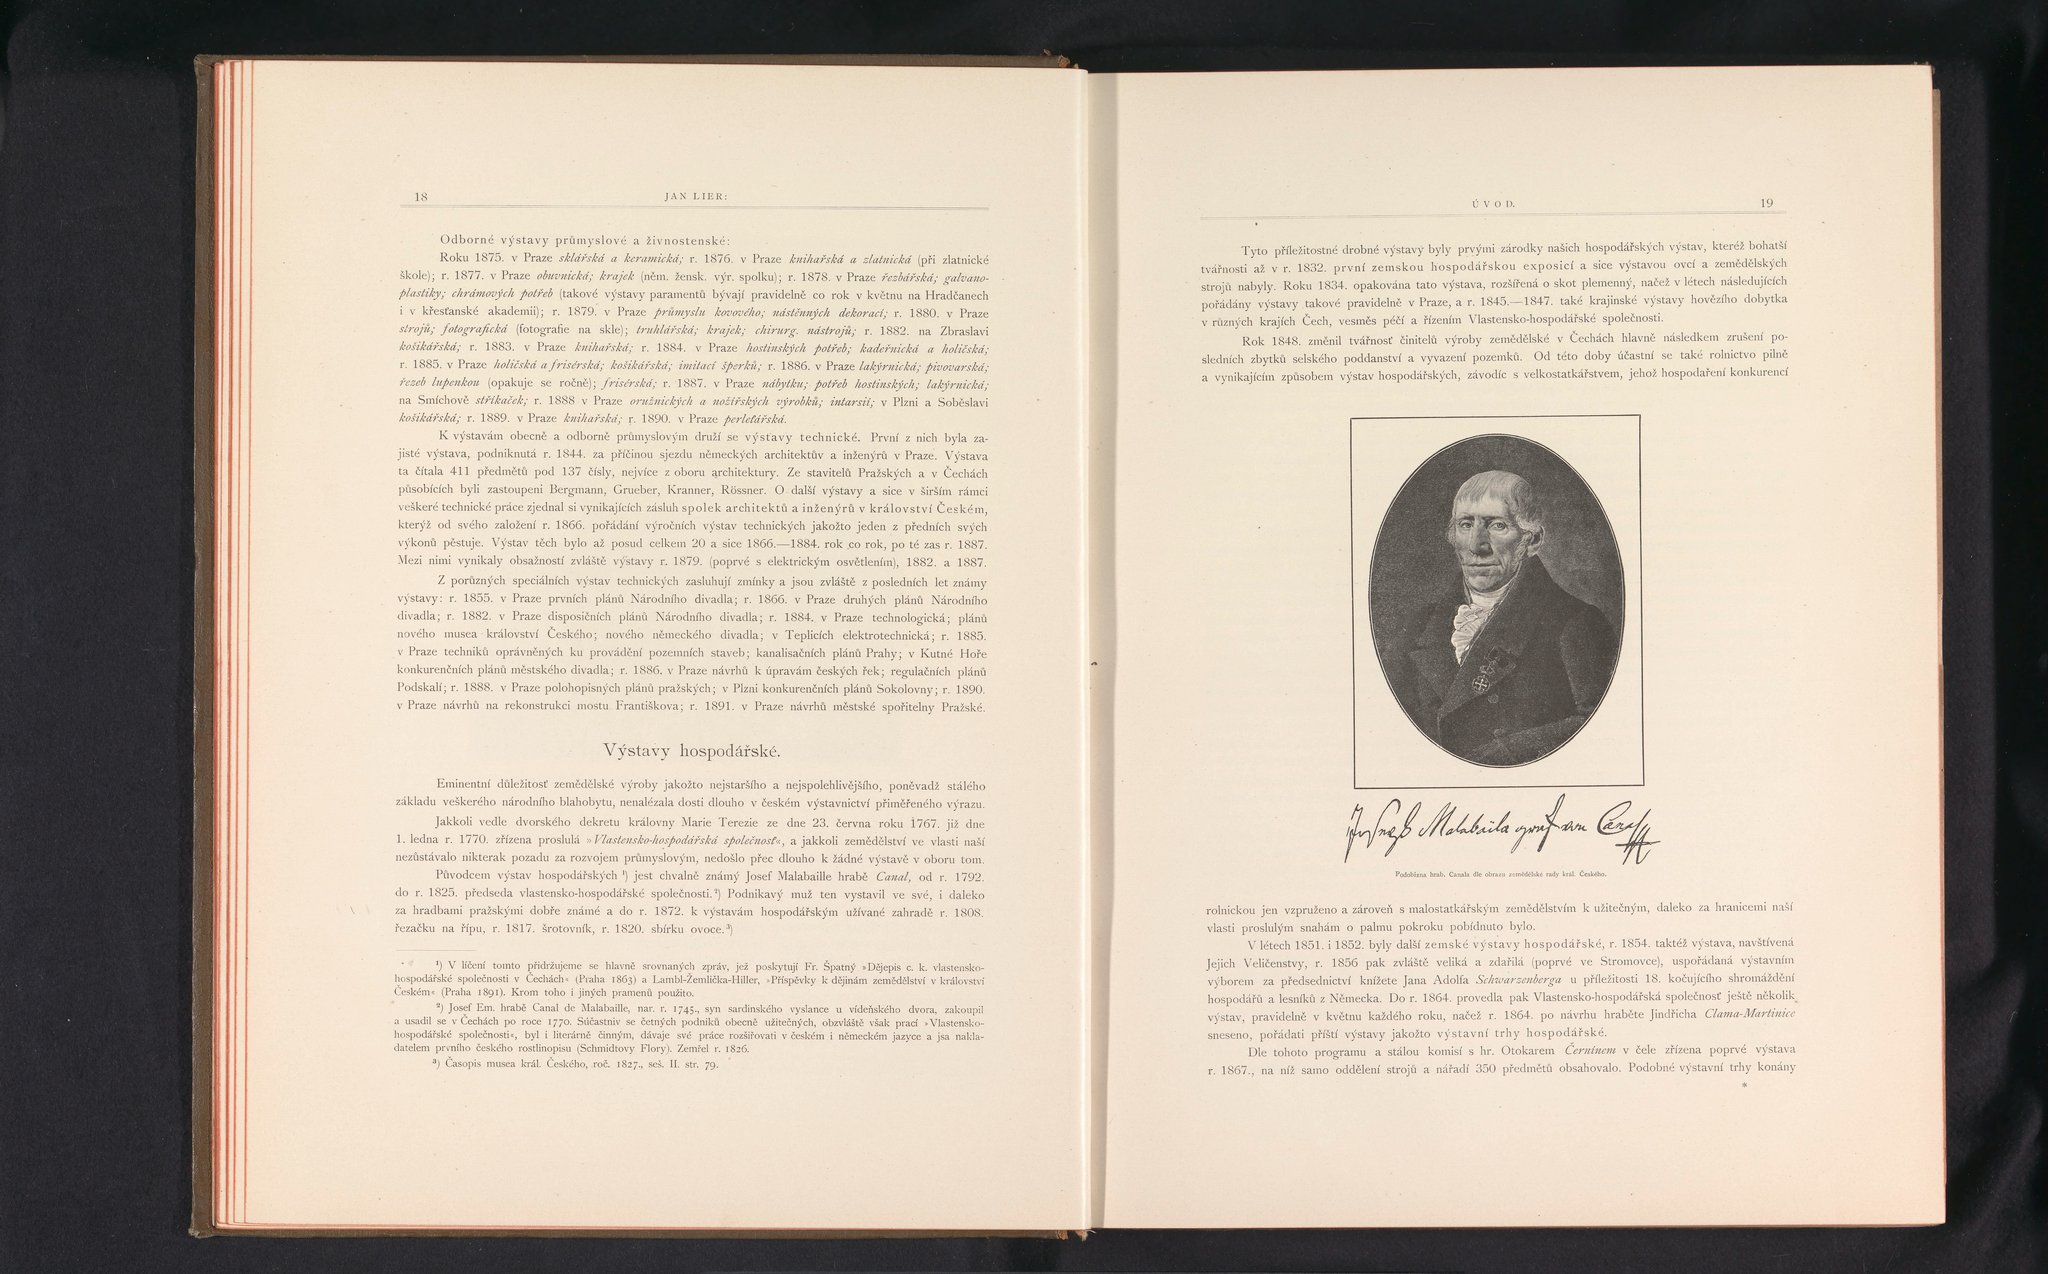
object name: page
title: Fotoreproductie van een schilderij, voorstellende een portret van Josef Emanuel Canal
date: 1888-1893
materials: paper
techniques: autotype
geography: prague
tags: adult man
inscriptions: inscription: ‘Jozef Malabaïla graf von Canal’